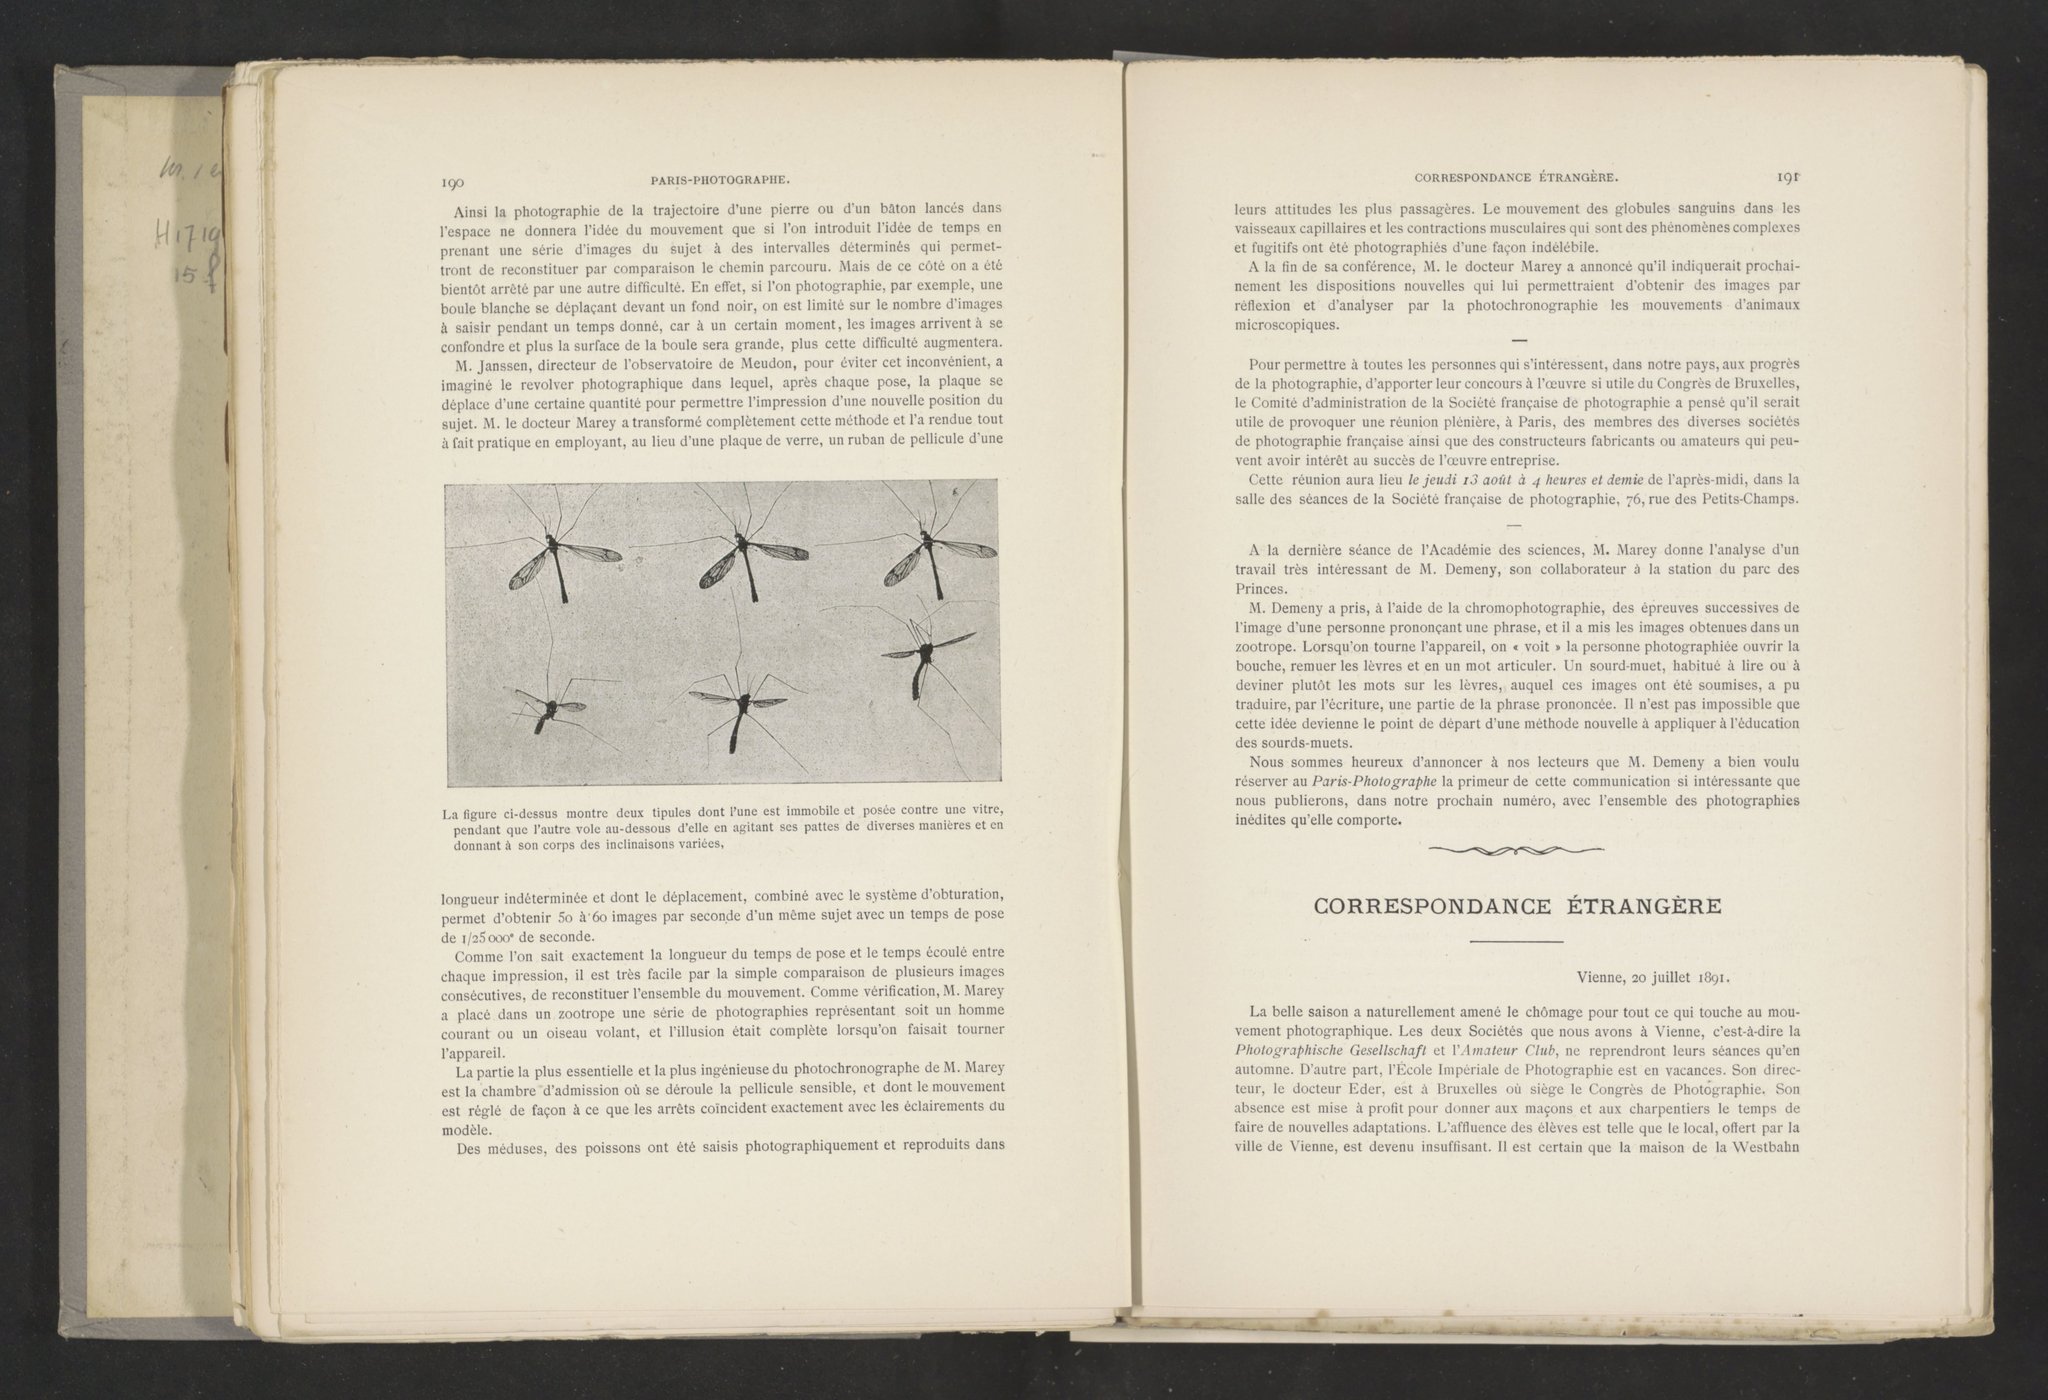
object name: page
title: Zes langpootmuggen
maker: Anonymous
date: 1881-1891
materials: paper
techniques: autotype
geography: france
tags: insects: mosquito